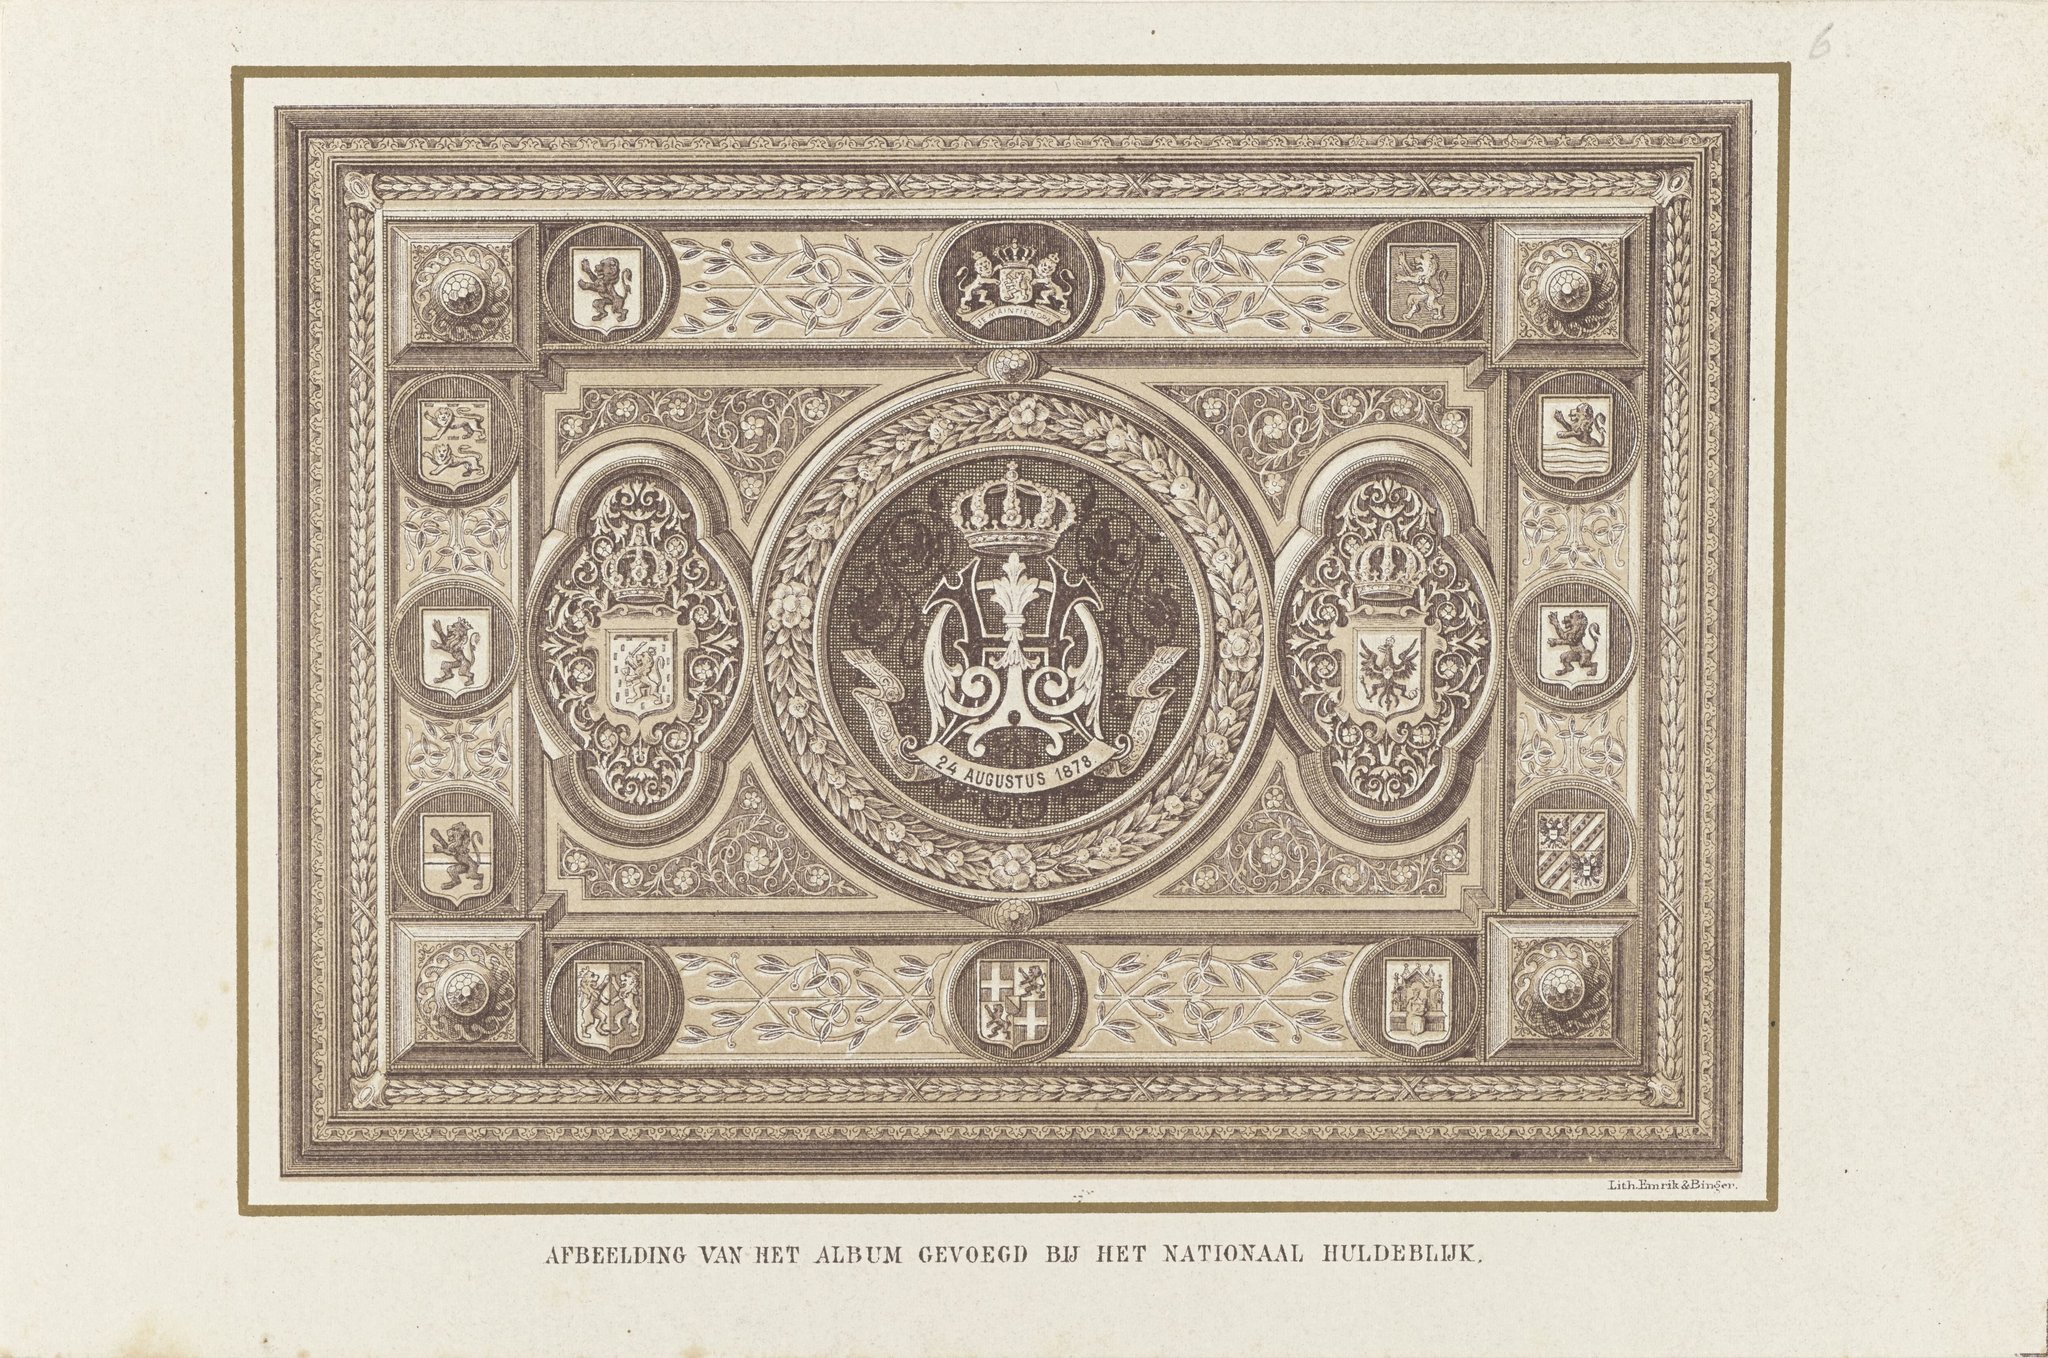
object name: print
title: Album bij het nationaal huldeblijk bij het huwelijk van prins He4ndrik en prinses Maria, 1878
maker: Anonymous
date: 1879-1880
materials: paper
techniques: tone lithography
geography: netherlands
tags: hendrik (prins der nederlanden), (civil) marriage ceremonies, wedding-gift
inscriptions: collector's mark: Lugt 2228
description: Album gevoegd bij het nationaal huldeblijk. Onderdeel van het souvenir bij het huwelijk op 24 augustus 1878 bestaande uit een reeks van acht prenten plus een begeleidend boekje.